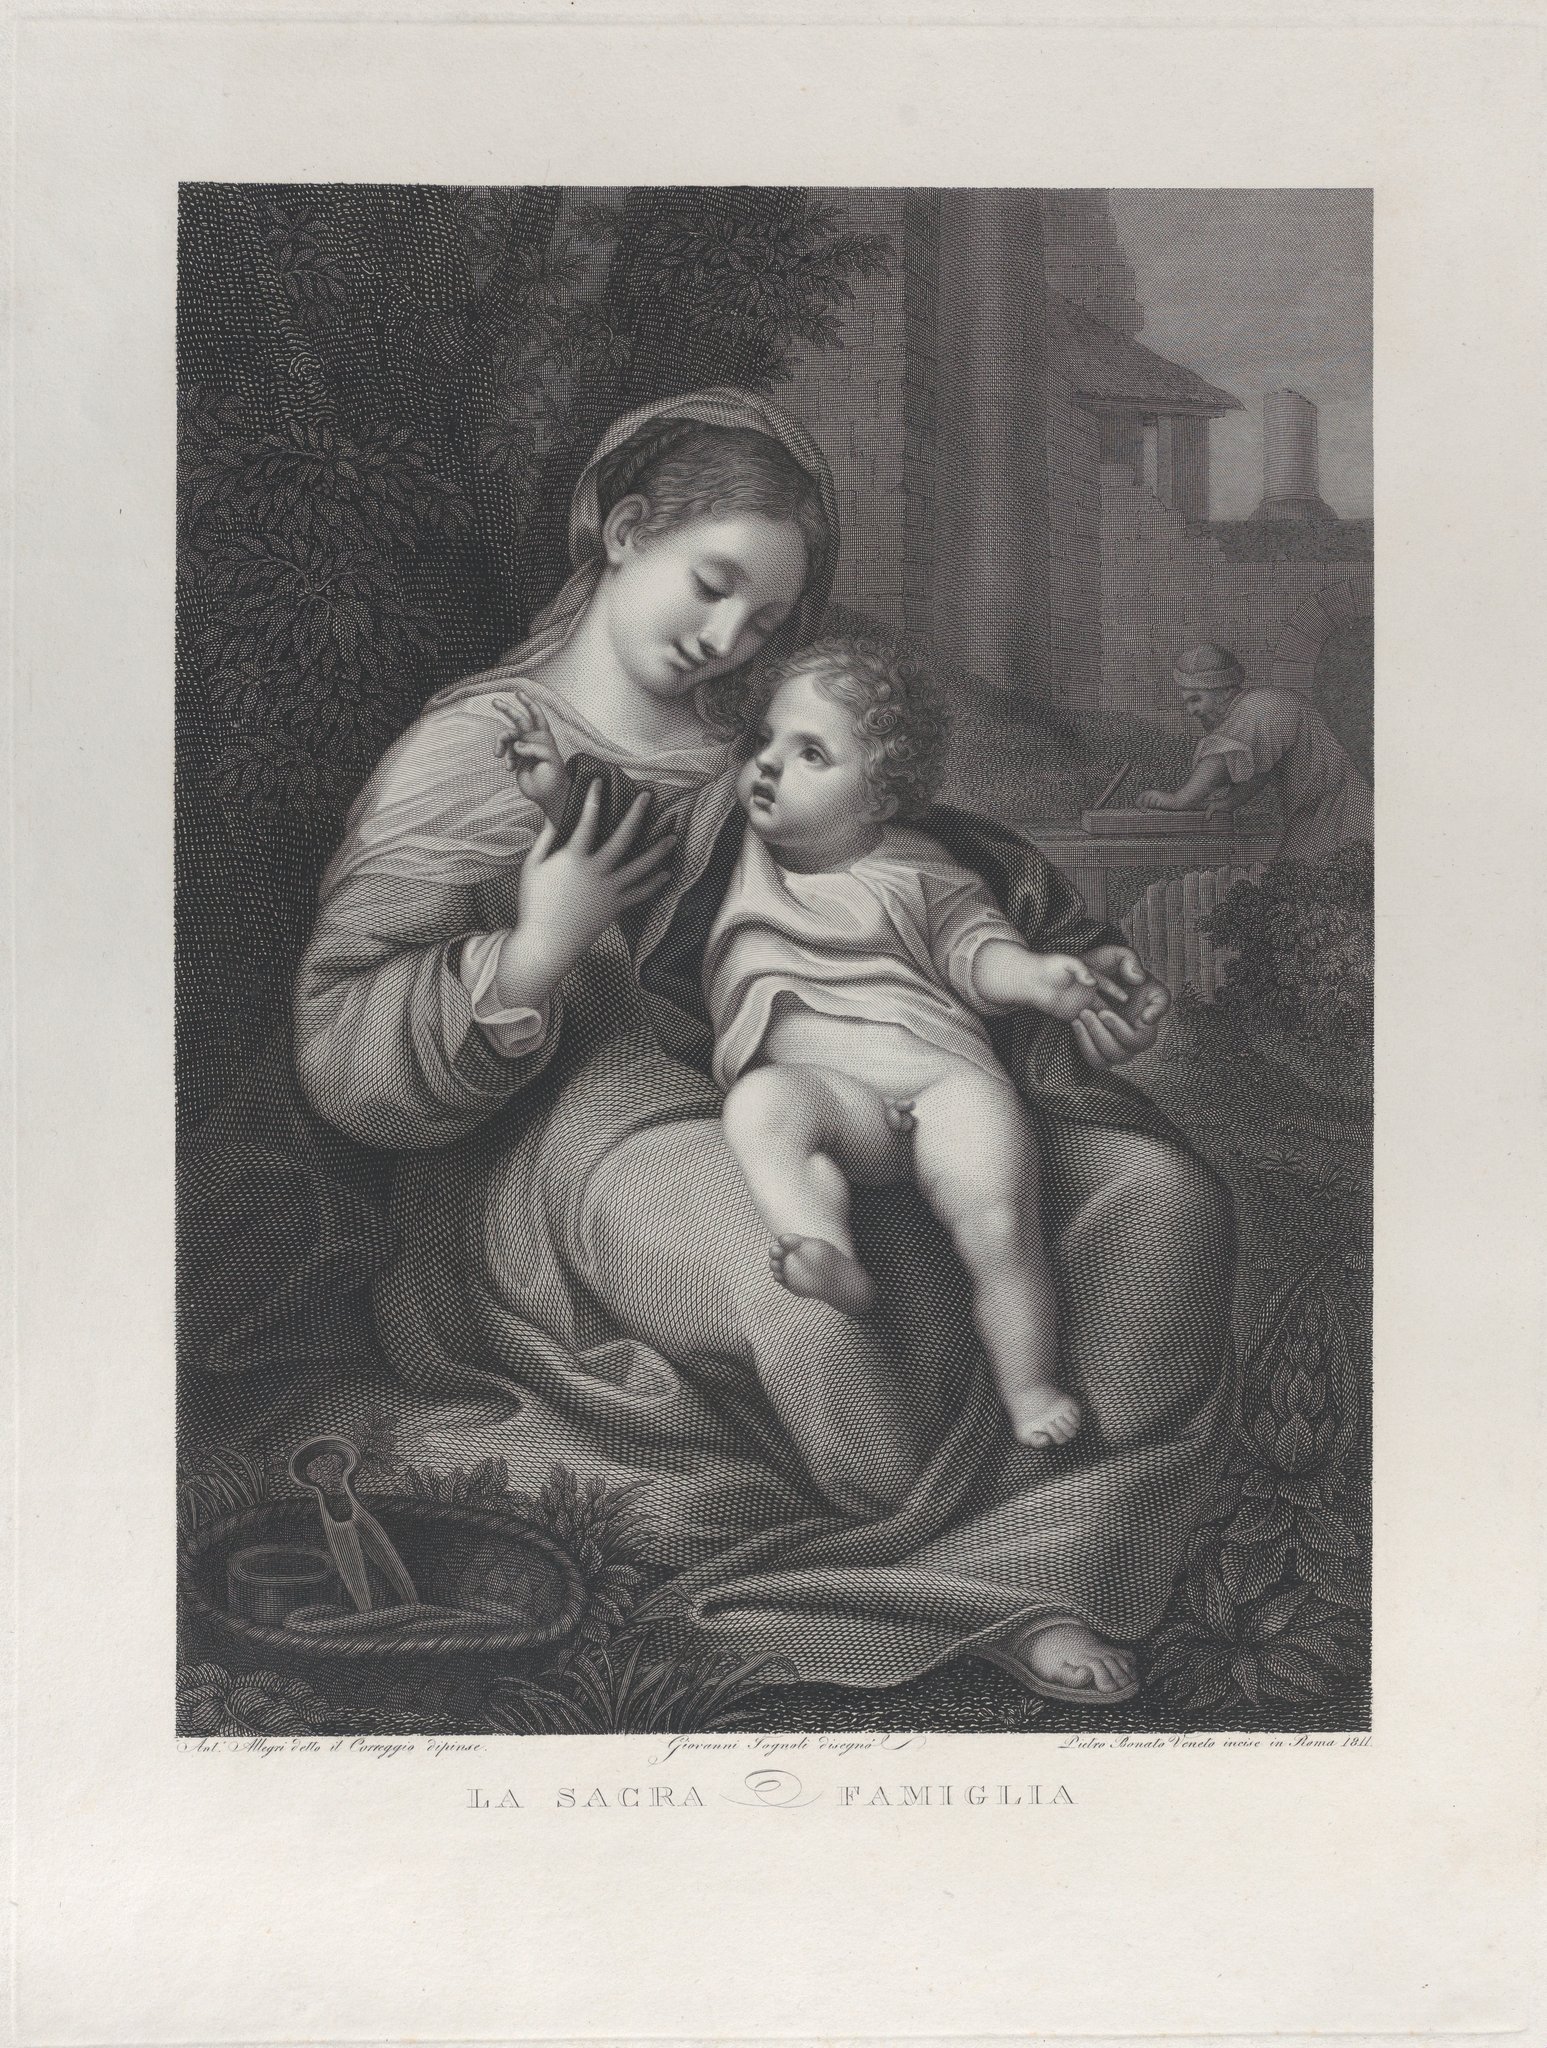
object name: print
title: The Holy Family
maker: pietro bonato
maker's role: artist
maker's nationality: italian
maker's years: 1765-1820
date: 1811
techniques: engraving